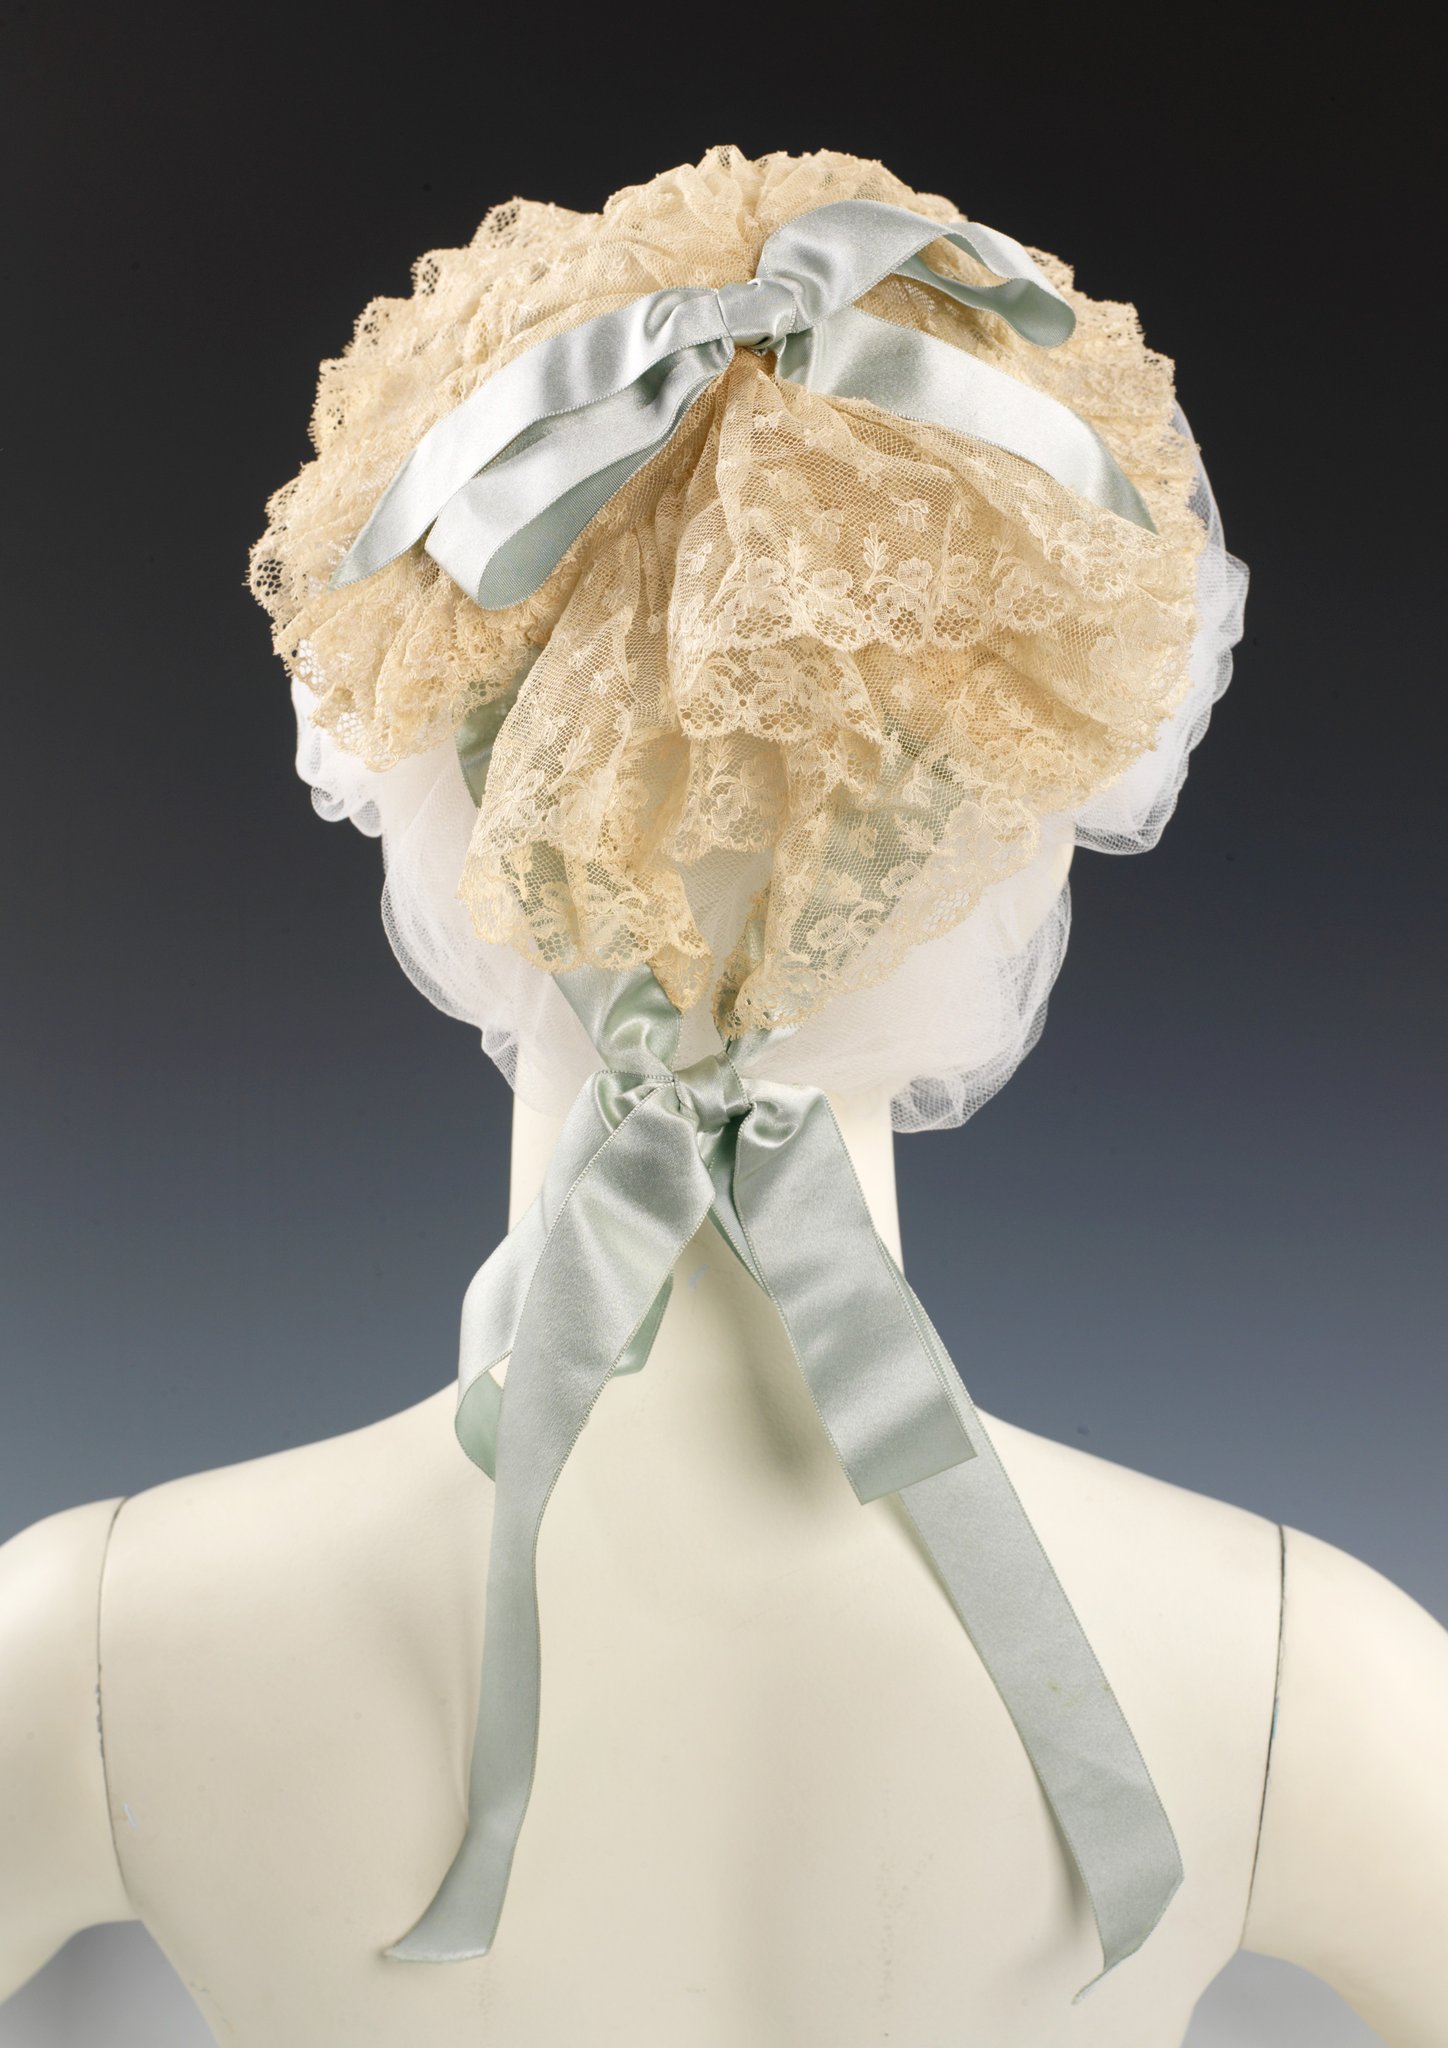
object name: morning cap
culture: american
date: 1890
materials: linen, silk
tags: flowers